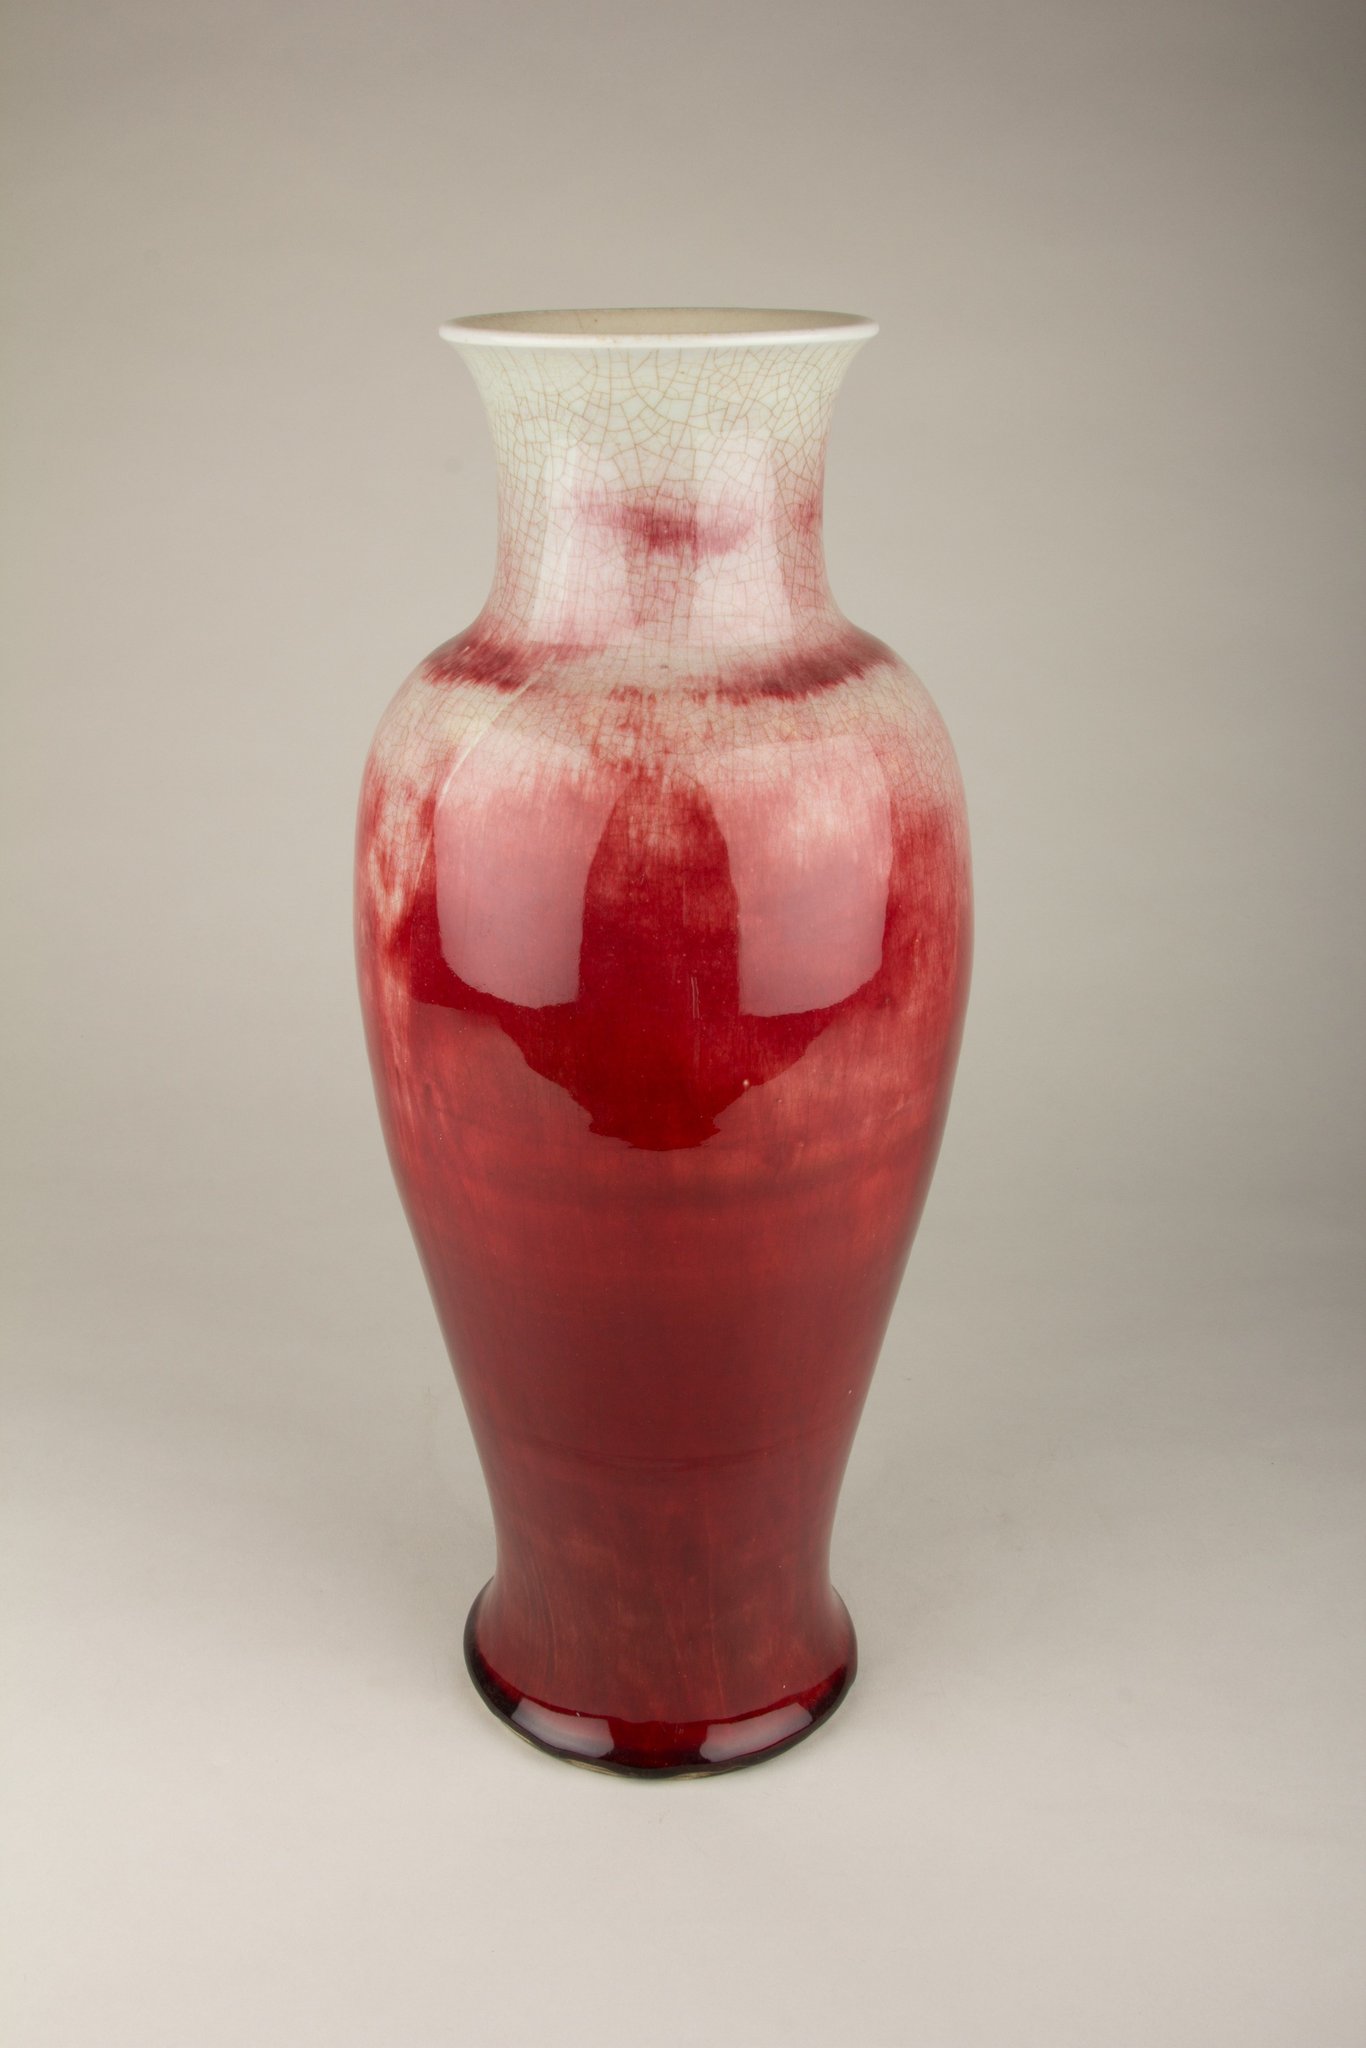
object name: vase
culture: chinese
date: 1662-1722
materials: copper, glaze, porcelain